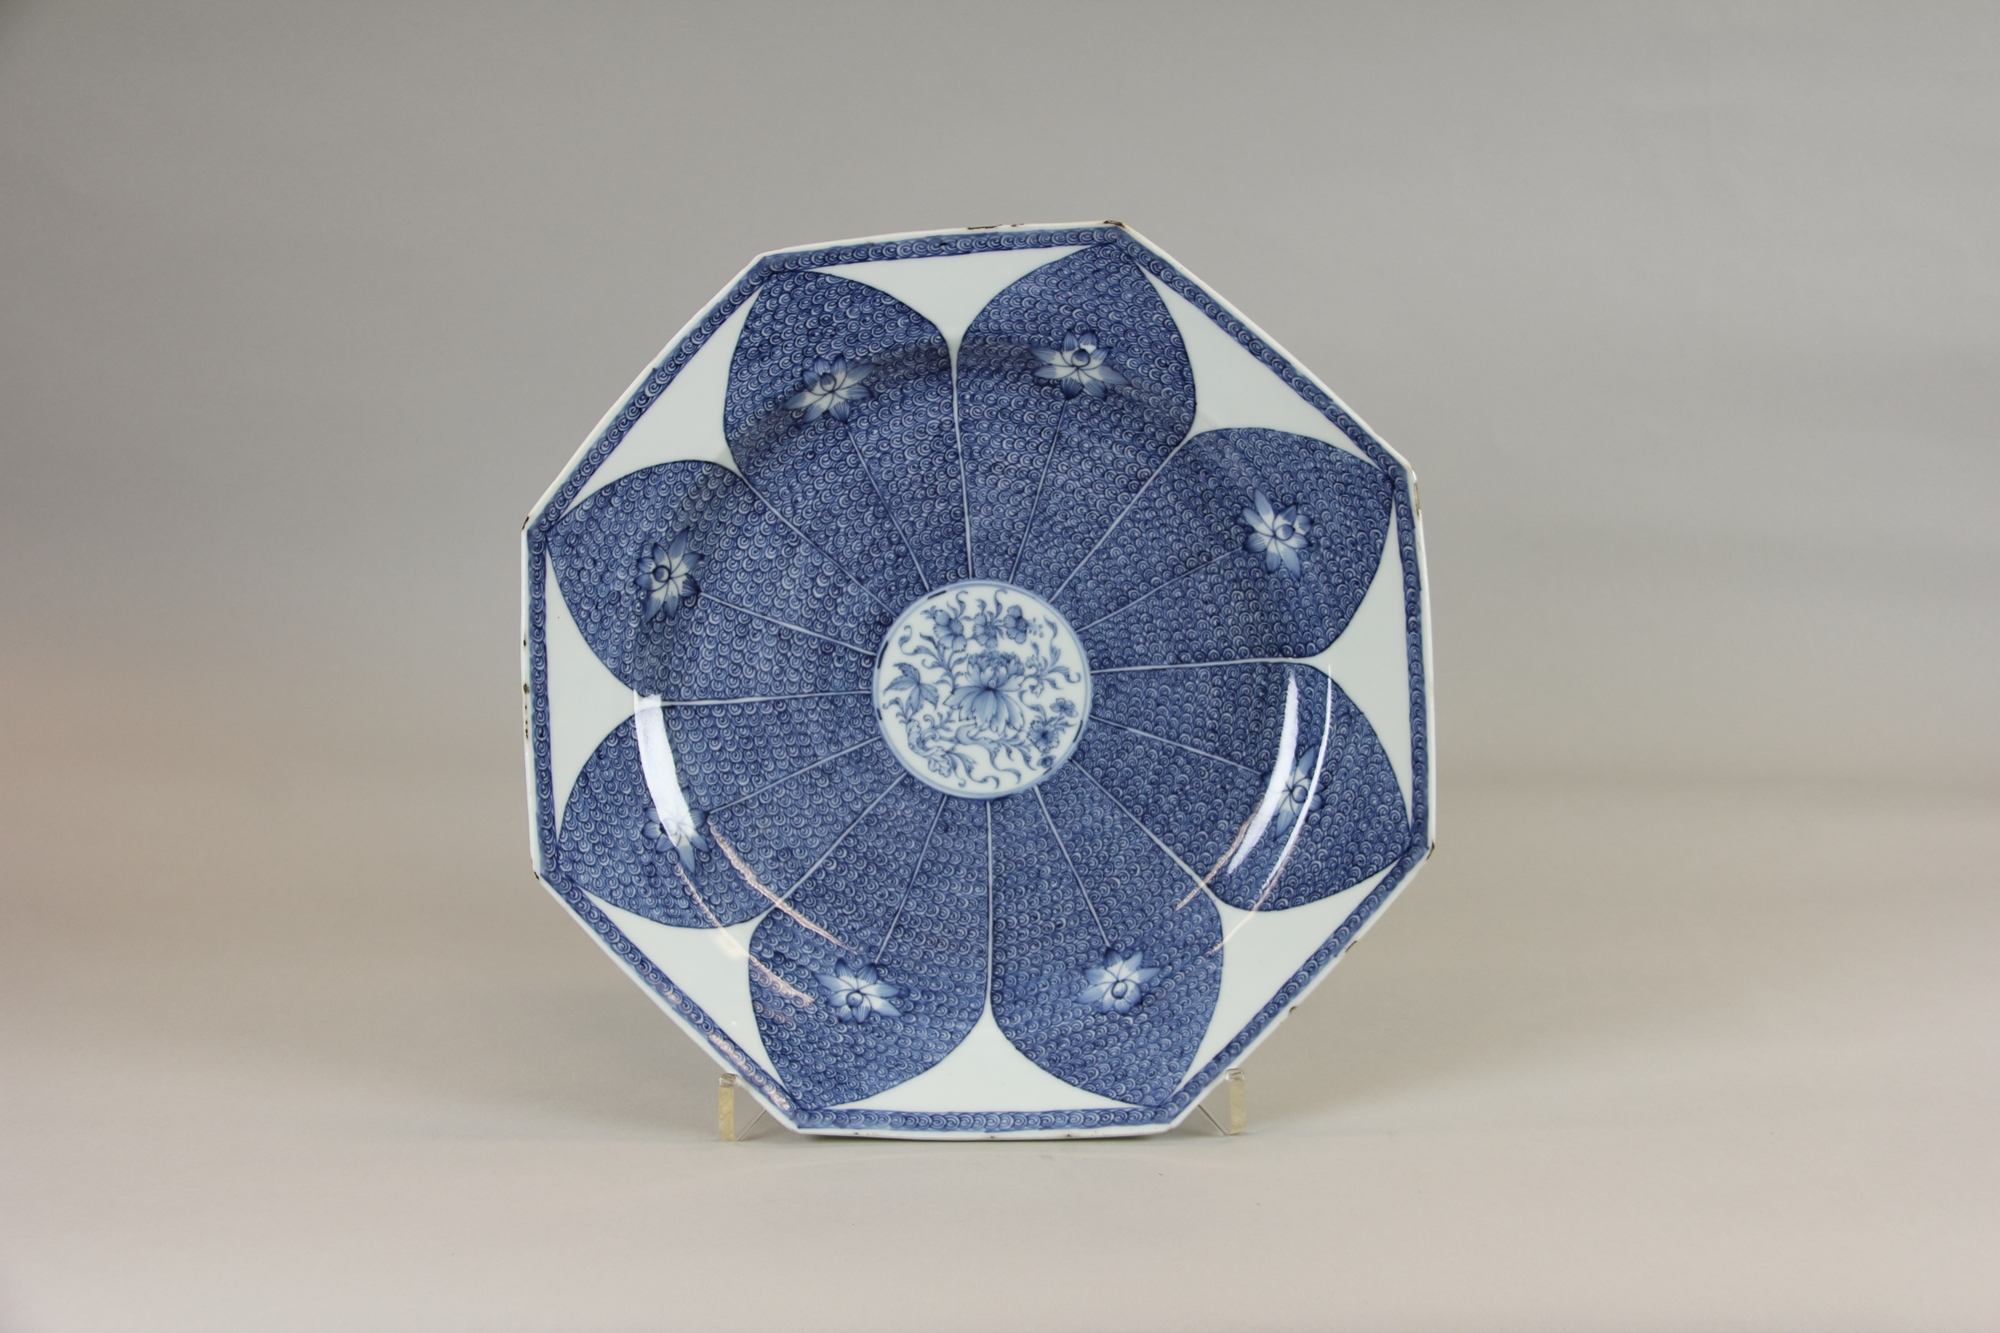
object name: plate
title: Octagonal plate with floral pattern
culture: chinese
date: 1701-1800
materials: cobalt, porcelain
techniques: painting, underglaze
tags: lotuses